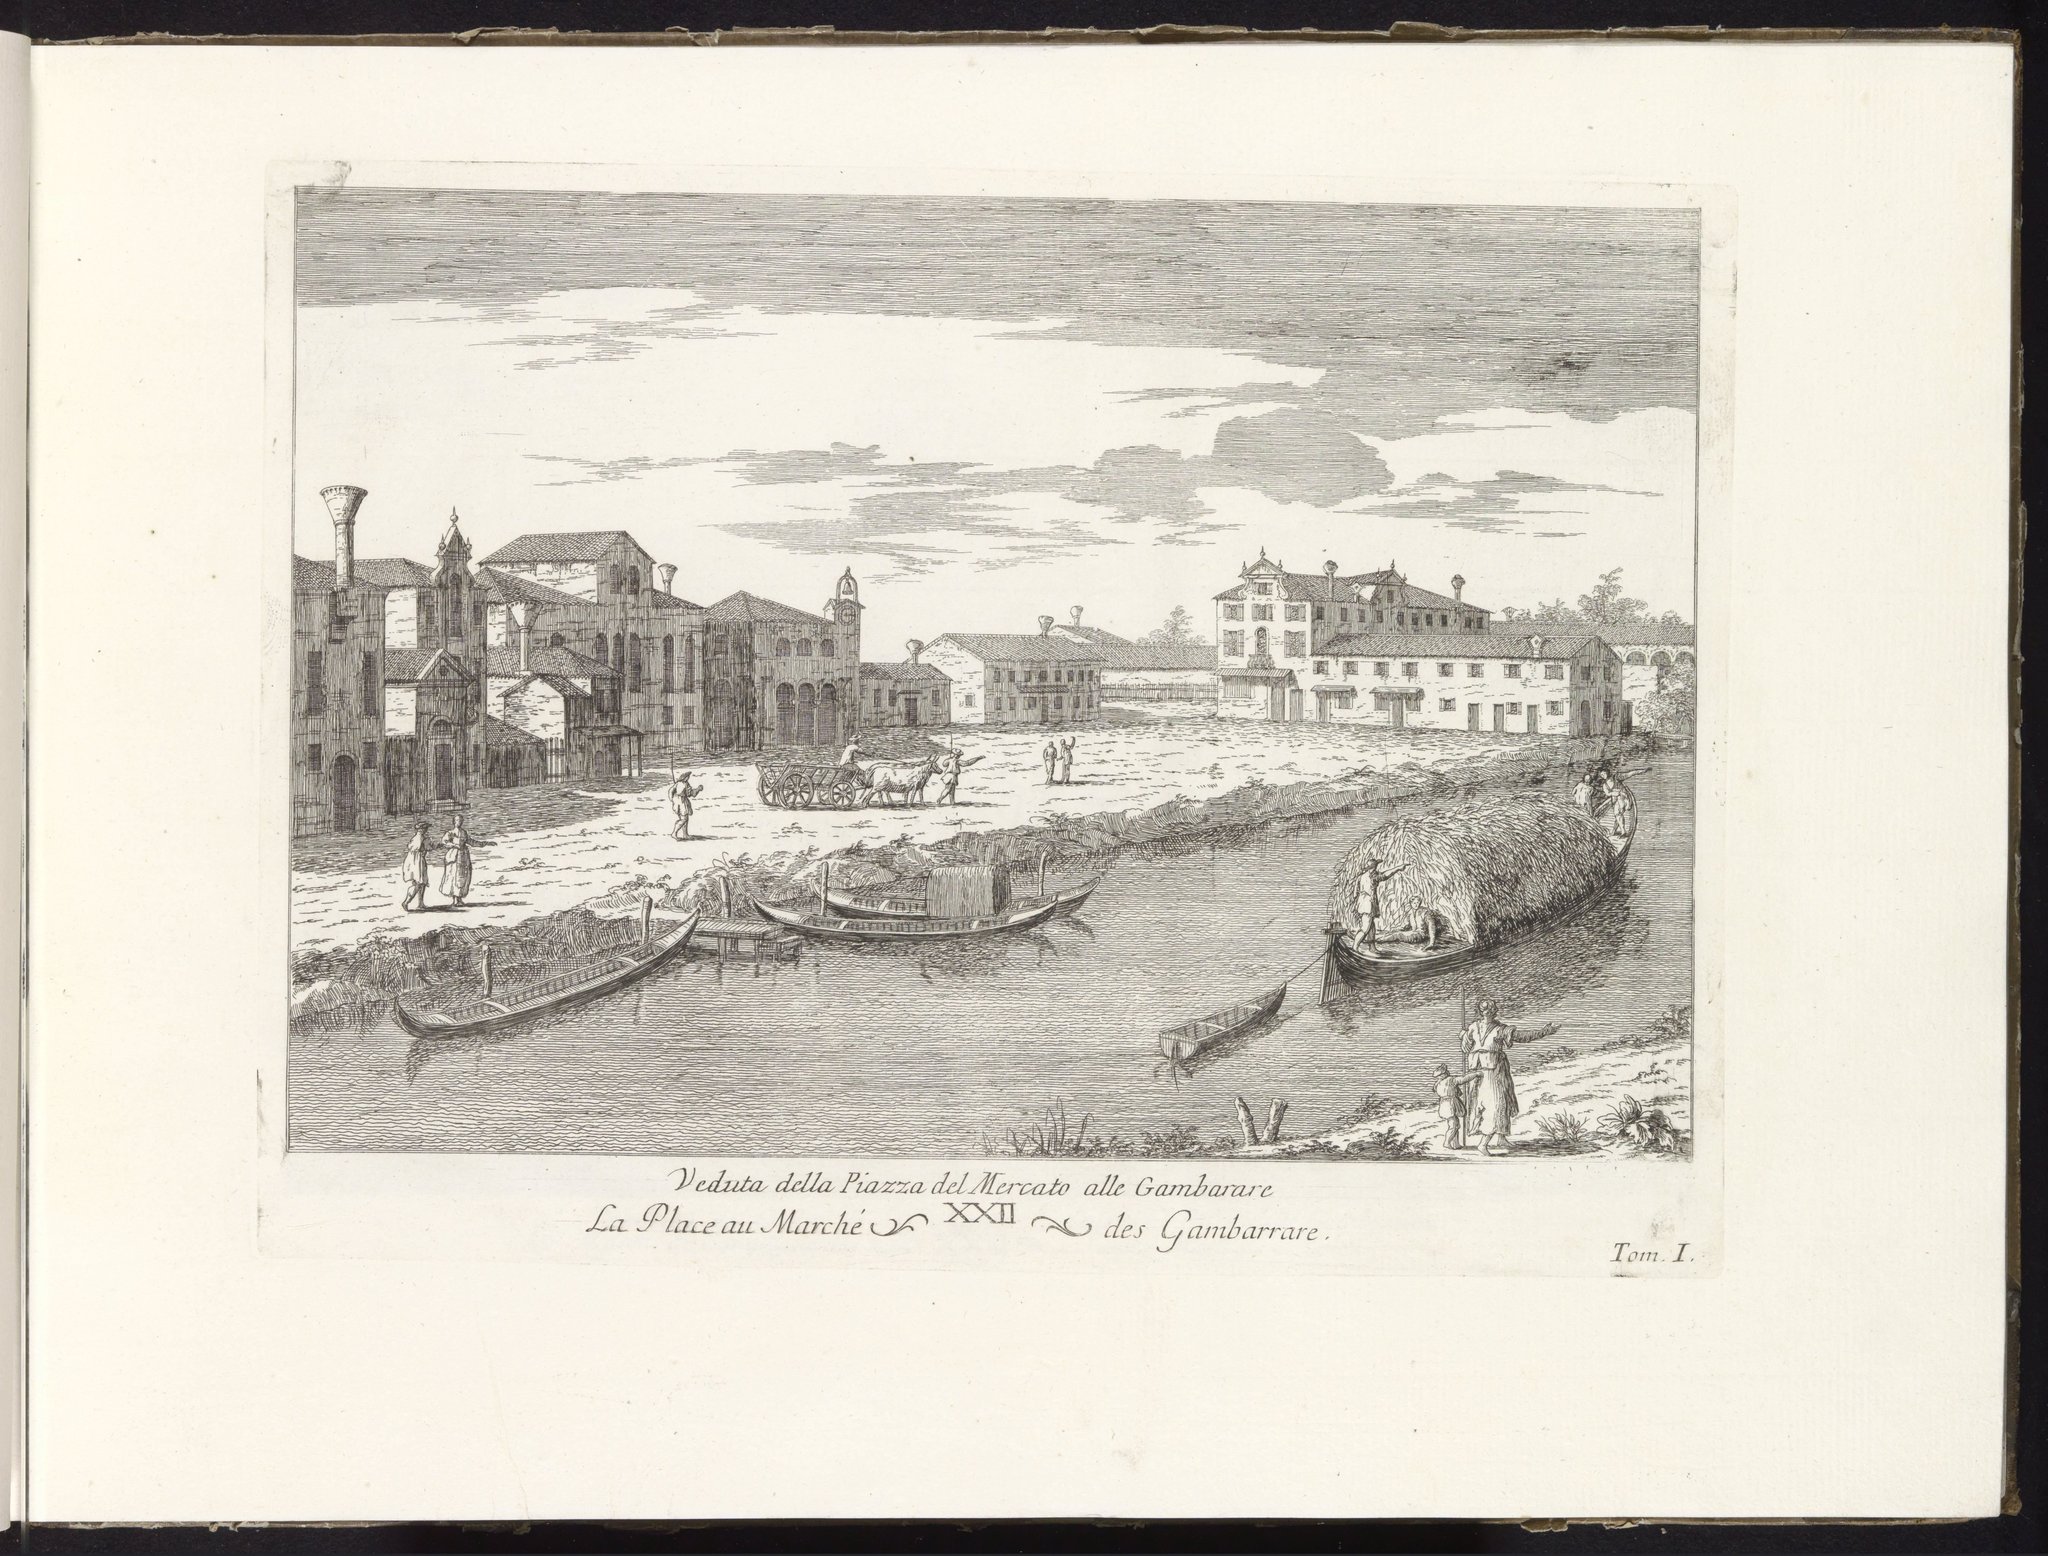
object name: print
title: Veduta della Piazza del Mercato alle Gambarar (...)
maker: giovanni francesco costa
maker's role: draughtsman, painter, print maker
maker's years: -1773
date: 1750-1760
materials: paper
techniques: etching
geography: venice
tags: square, place, circus, etc., river, ships (in general)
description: Gezicht op het Piazza del Mercato alle Gambarare aan de rivier de Brenta. Op het water vaart een schuit vol met hooi. Genummerd midden onder: XXII en rechtsonder: Tom: I. Deze prent maakt deel uit van een album.